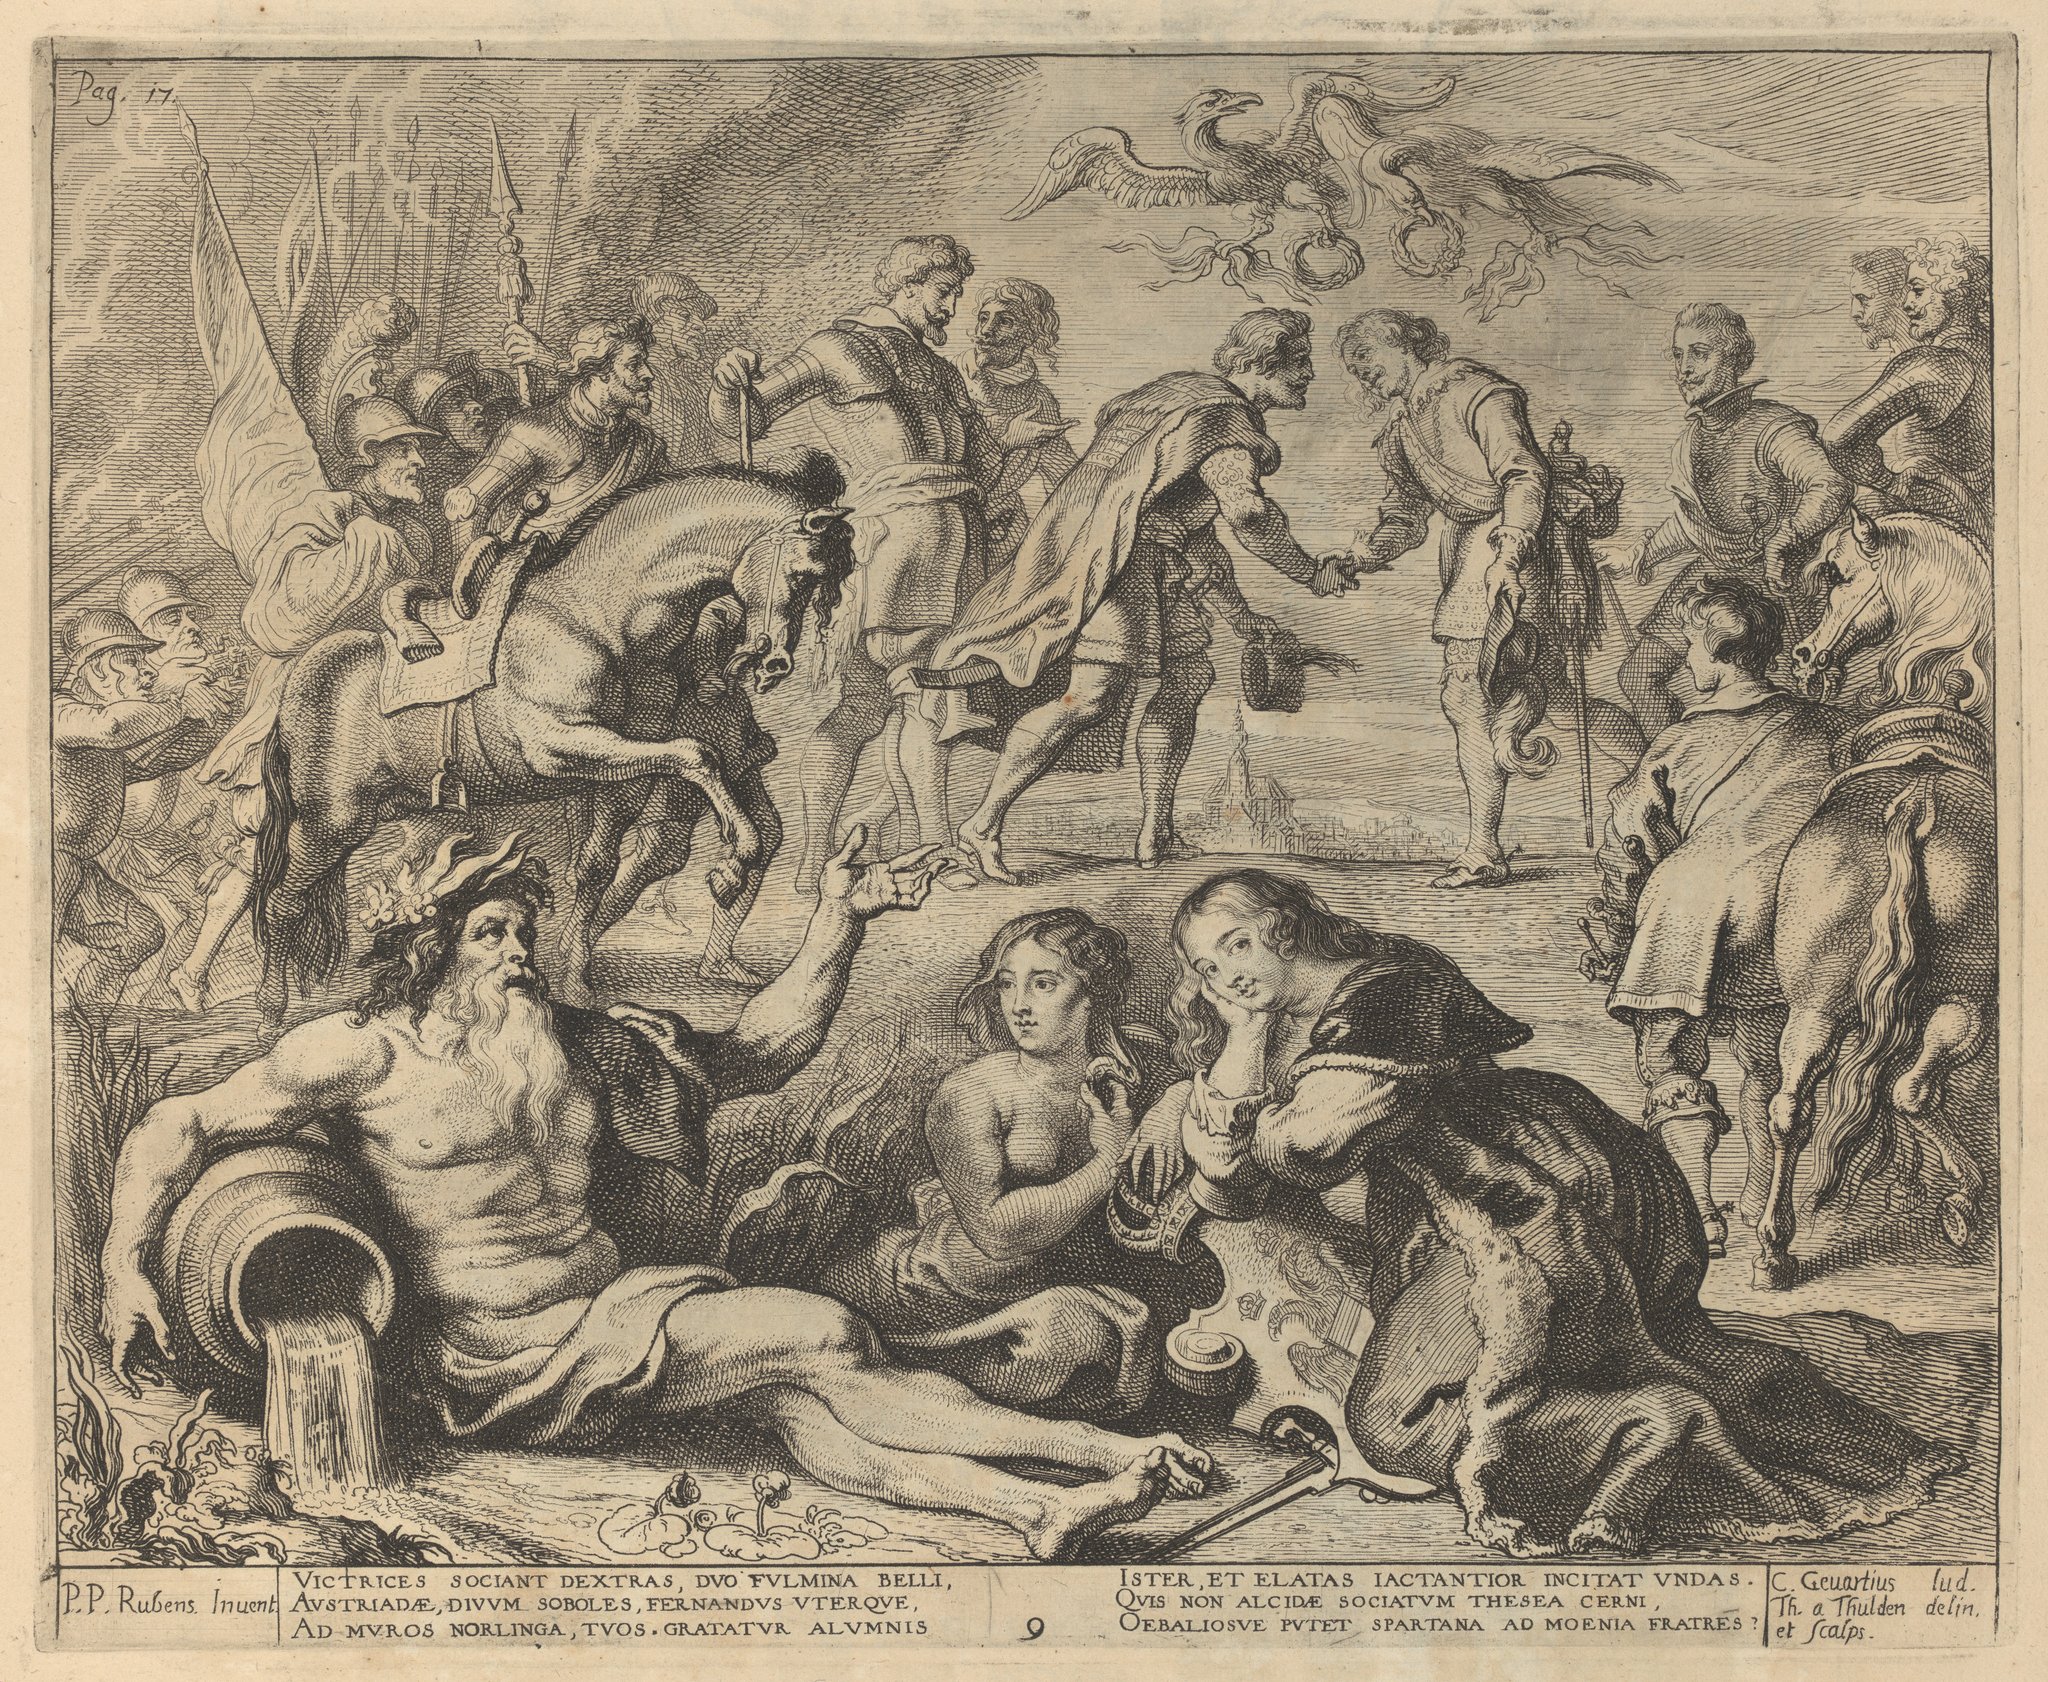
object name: book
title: Pompa Introitus Honori .. Ferdinandi Austriaci ... " (Entry of Cardinal-Infante Ferdinand into Antwerp, April 17, 1635)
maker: peter paul rubens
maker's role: designer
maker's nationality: flemish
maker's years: 1577-1640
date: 1642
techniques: engraving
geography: antwerp, n.d.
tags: soldiers,men,women,dragons,horses